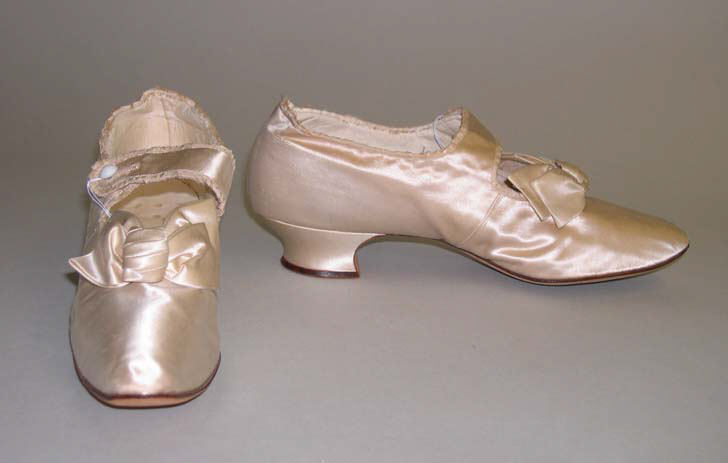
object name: wedding slipper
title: Wedding slippers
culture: american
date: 1894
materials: leather, metal, silk